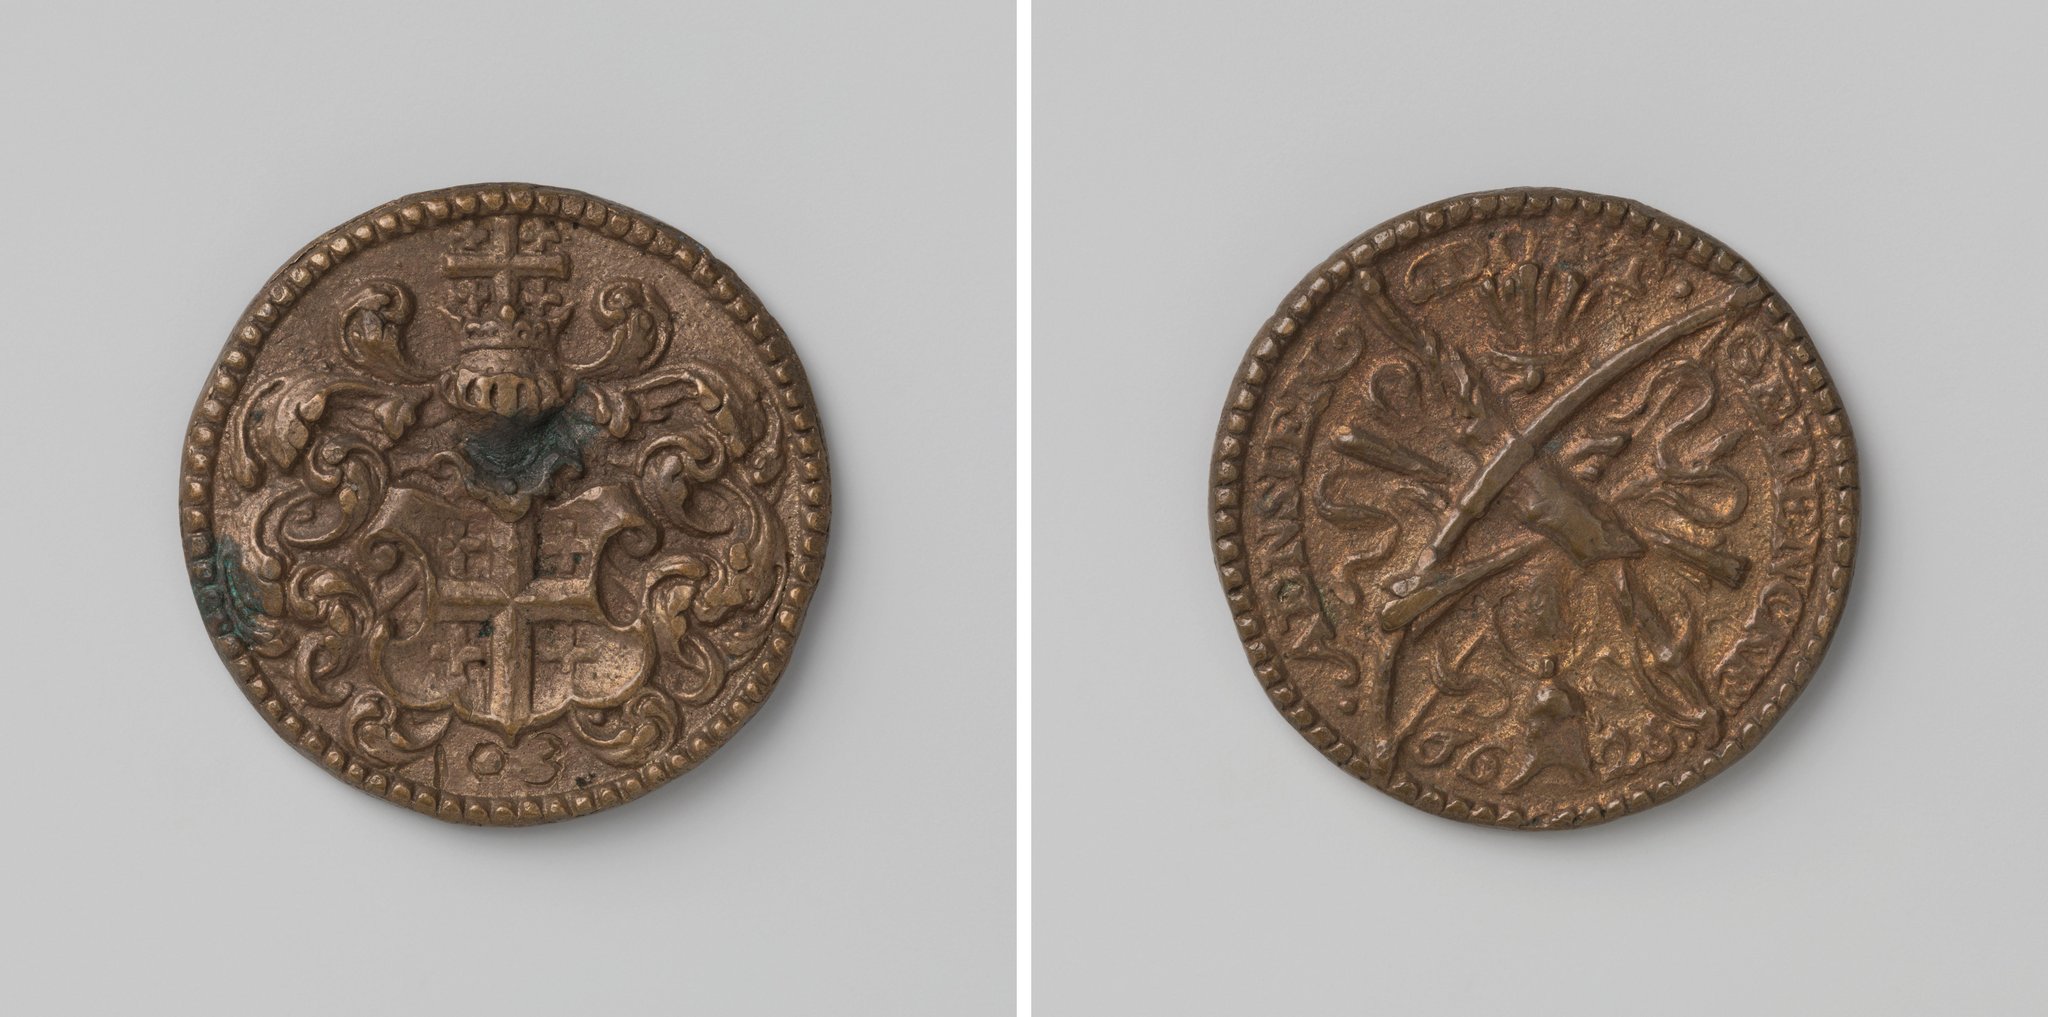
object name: marksman medal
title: Confrerie van de Edele Handboog te Middelburg, schutterspenning met no. 103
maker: johannes looff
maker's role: die cutter, draughtsman, print maker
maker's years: -1651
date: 1628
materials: copper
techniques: casting, engraving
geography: middelburg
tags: middelburg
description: Koperen penning. Voorzijde: gehelmd wapenschild, omgeven door siermotief boven cijfer 103. Keerzijde: wapentrophee bestaande uit pijlkoker met afhangende kwast, een gespannen en een opgerolde boog en losse pijlen, omgeven door kronkelende linten binnen omschrift